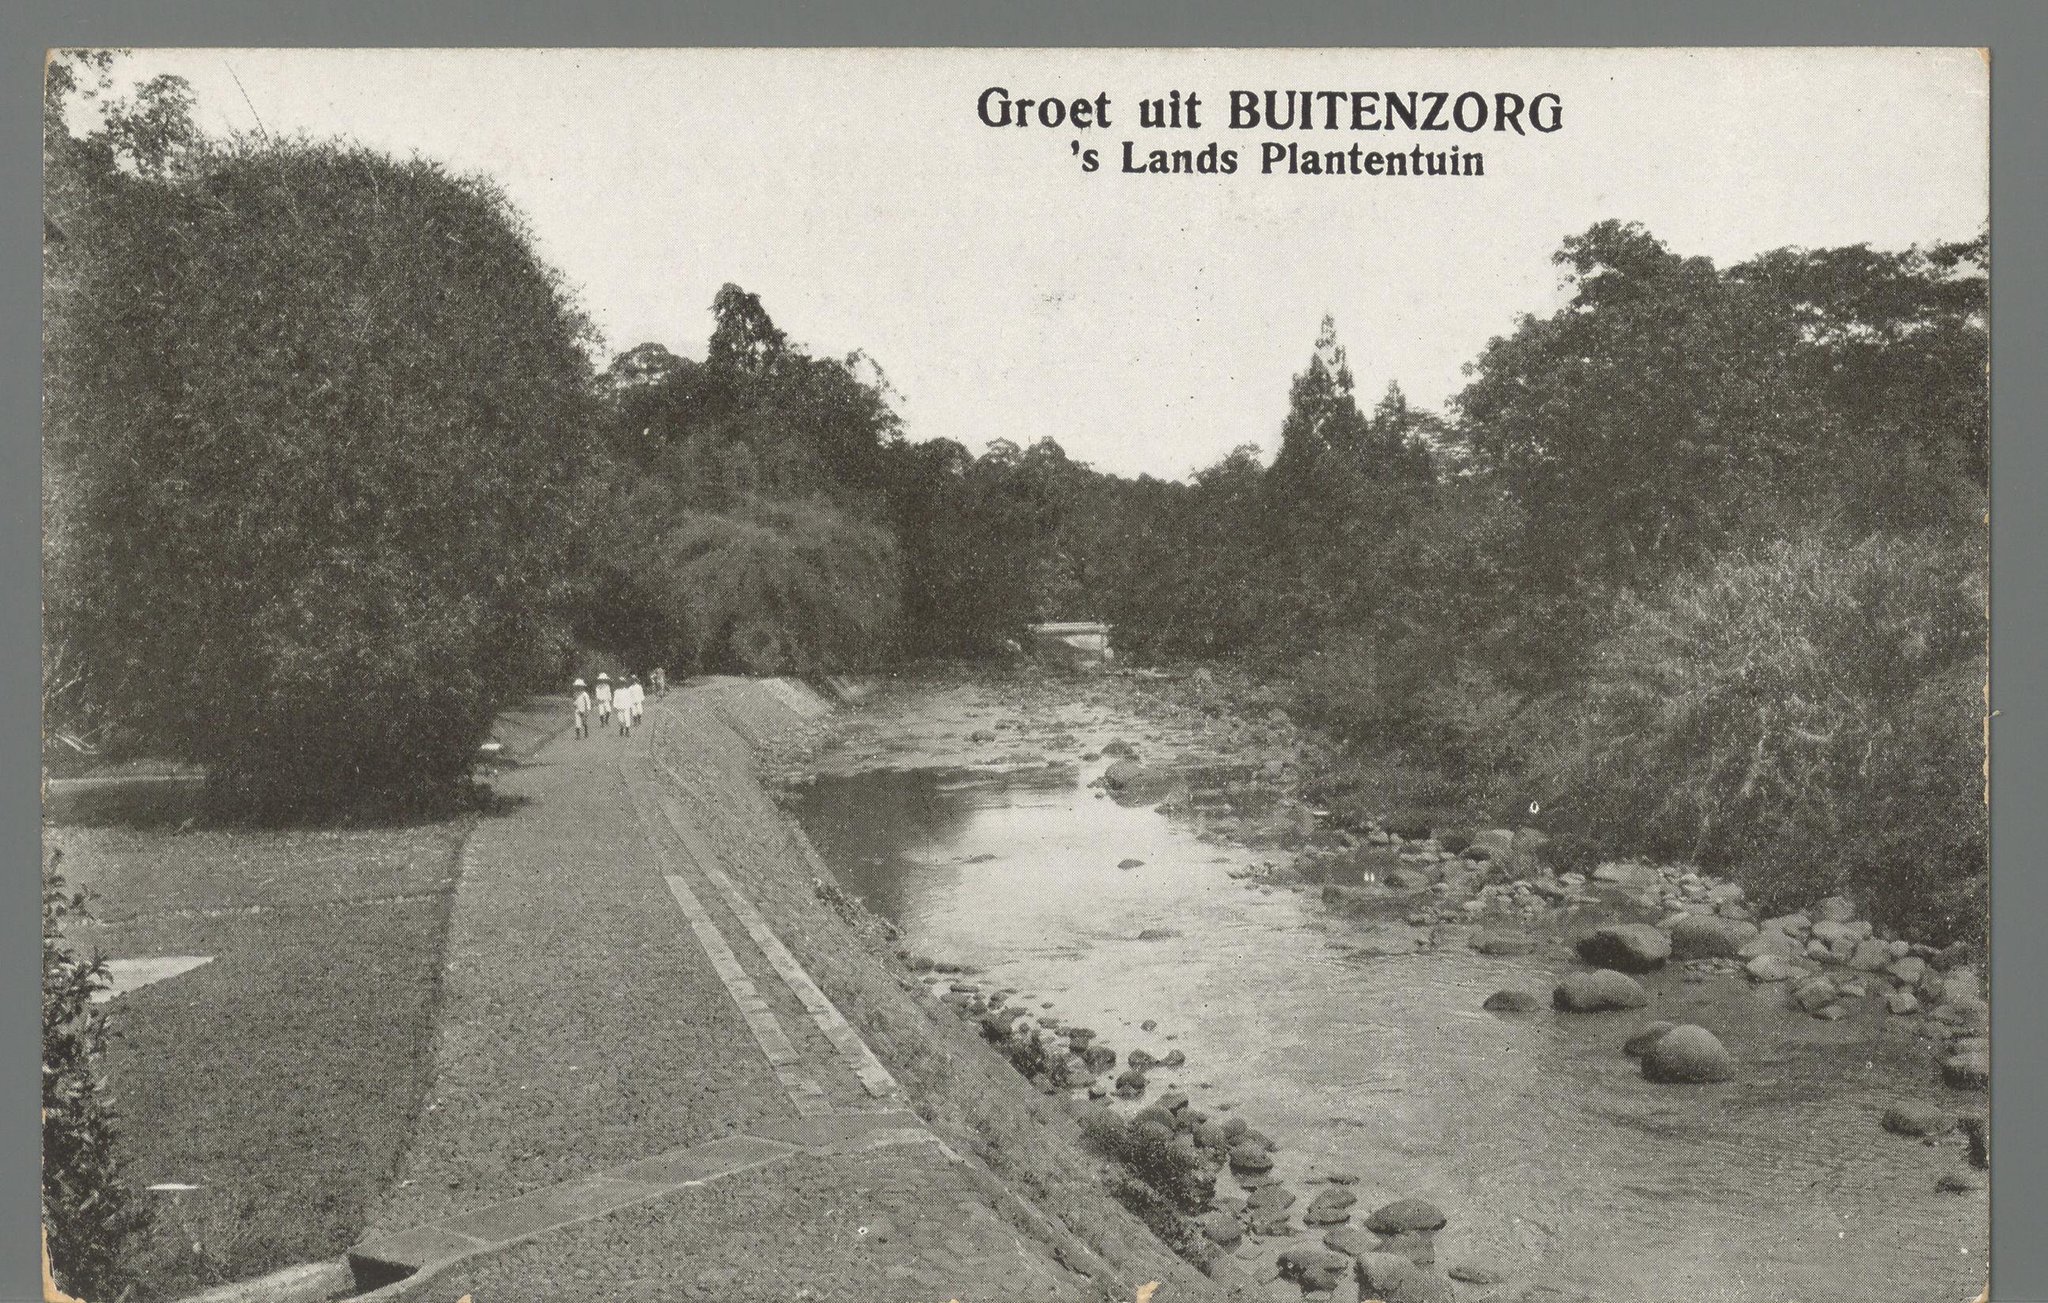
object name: photomechanical print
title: Groet uit Buitenzorg. 's Lands Plantentuin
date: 1906-1930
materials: cardboard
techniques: autotype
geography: buitenzorg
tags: river, botanic garden, 'hortus botanicus'